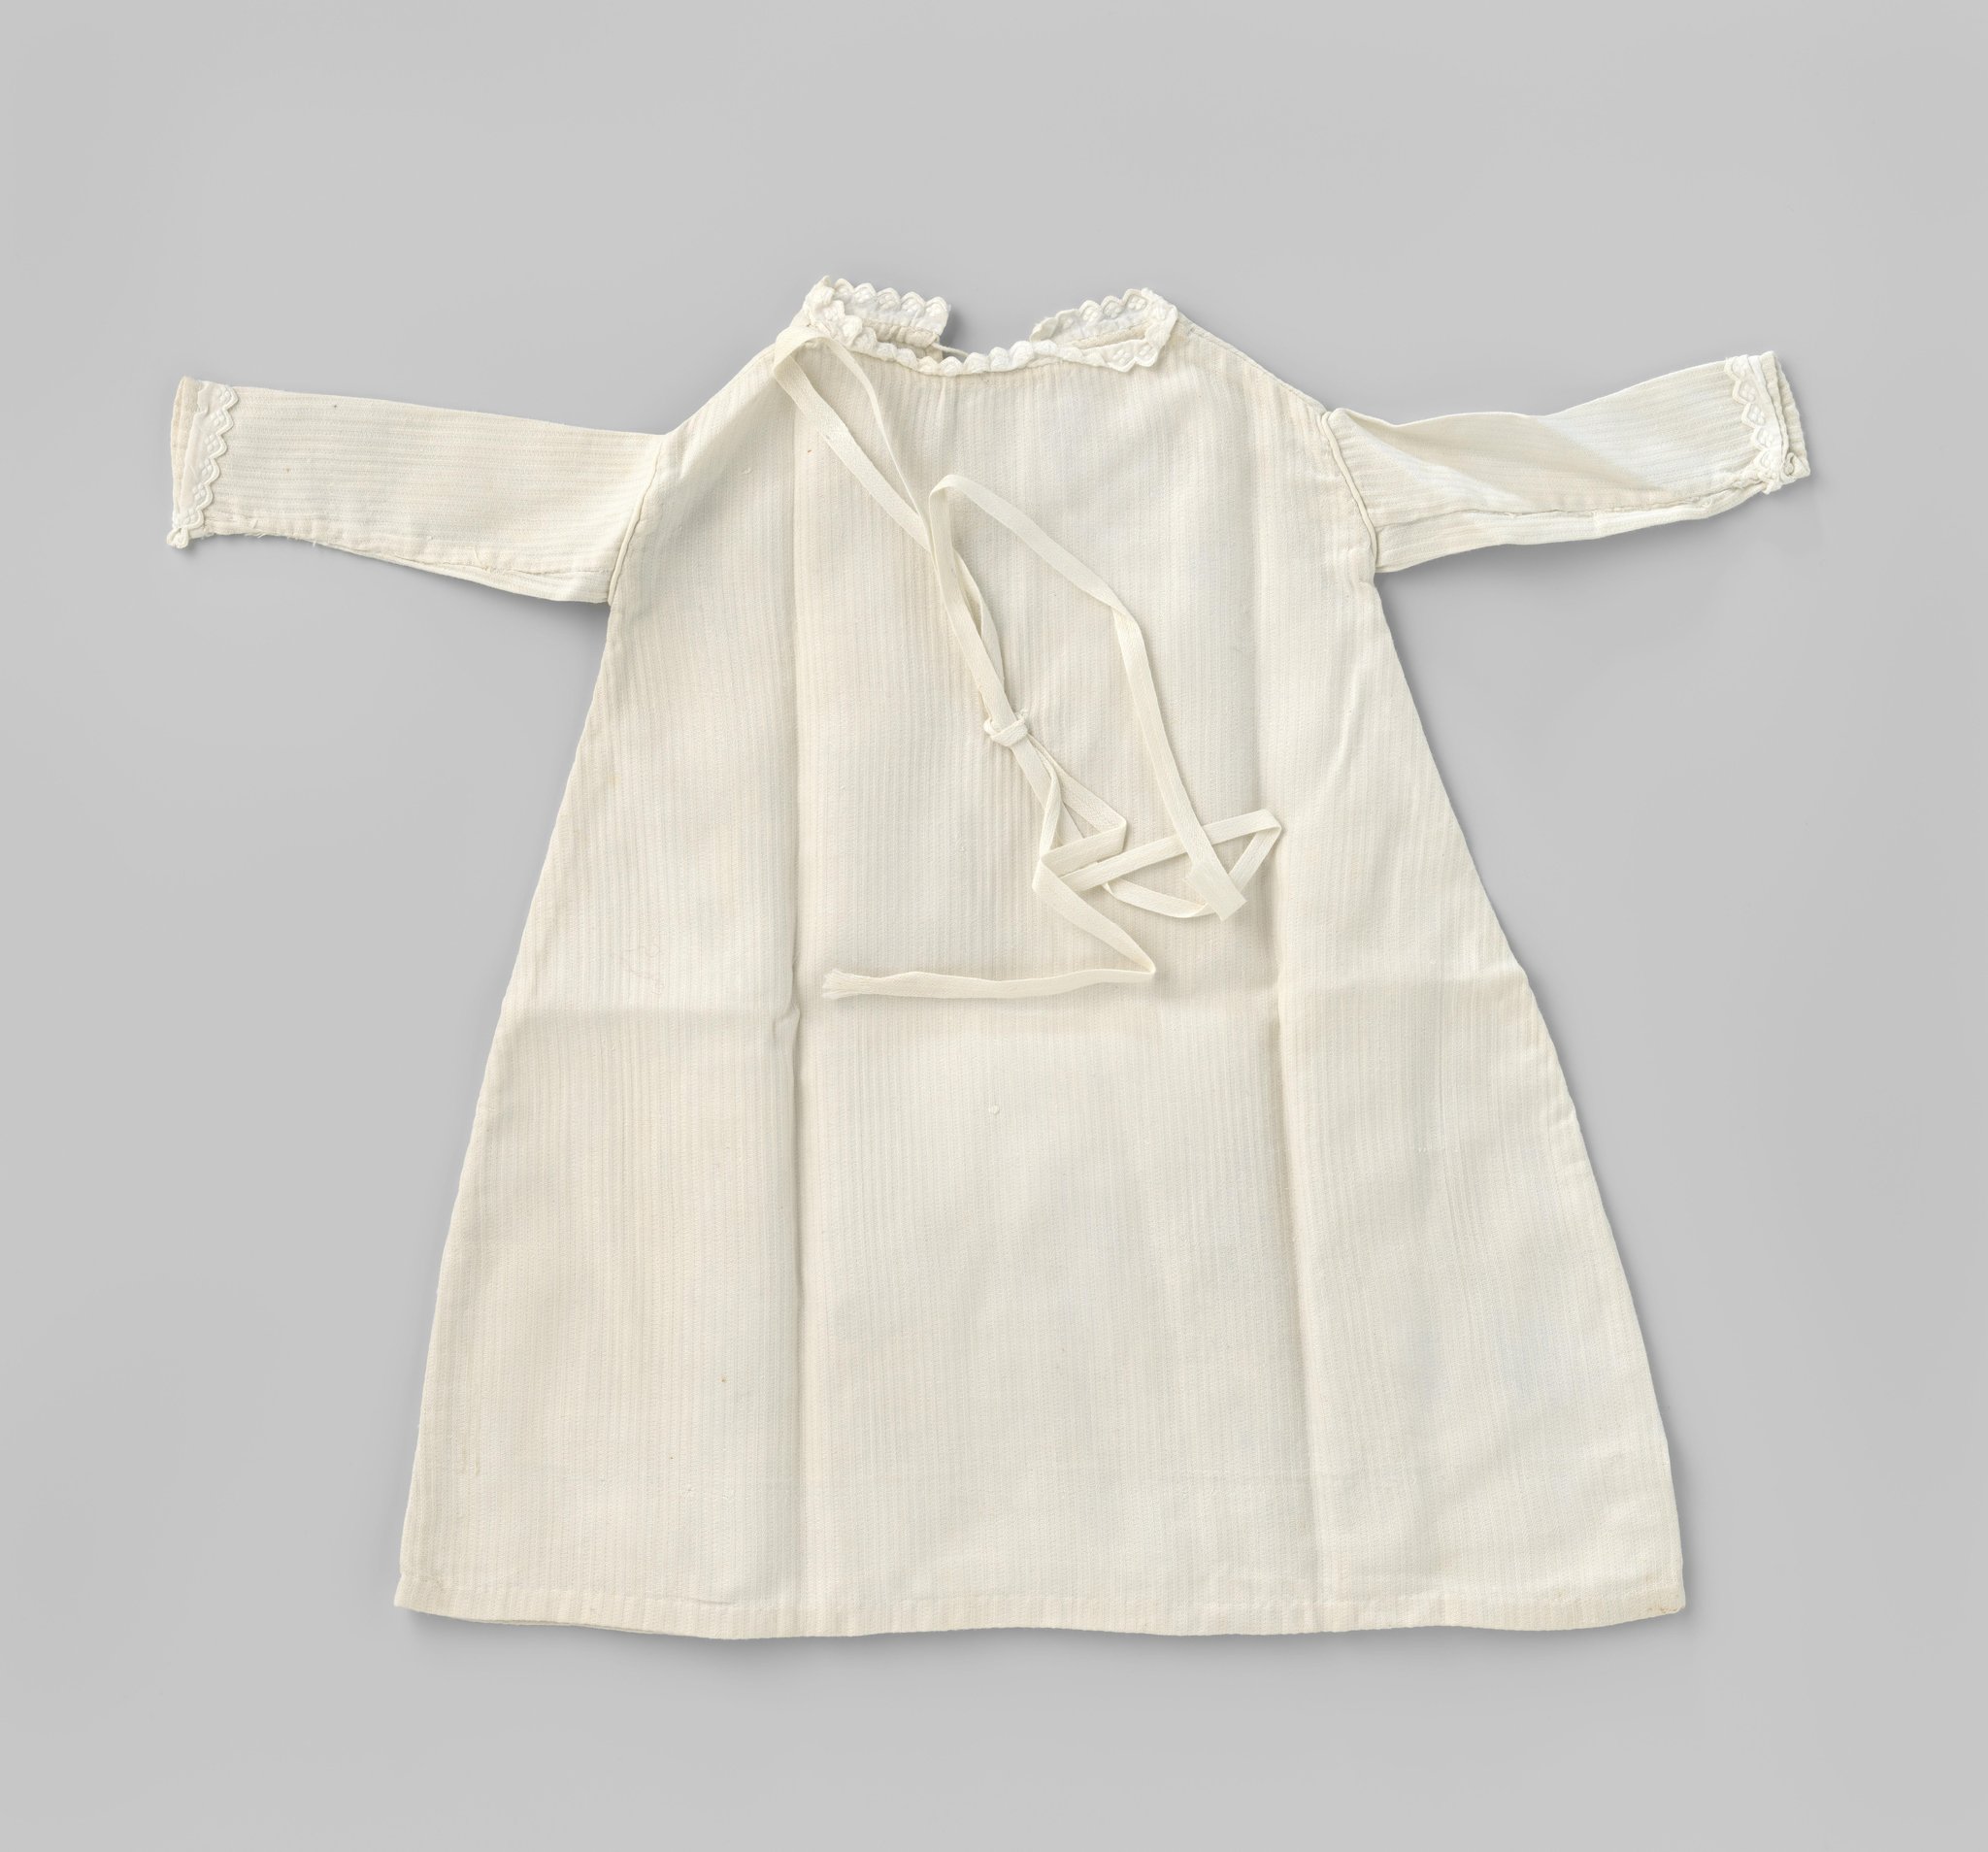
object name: doll's clothing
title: Hemd voor pop van wit linnen met ingeweven verticale strepen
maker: Anonymous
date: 1850-1920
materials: textile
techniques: weave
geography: netherlands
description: Het hemd heeft lange mouwen en is langs de hals en aan het uiteinde van de mouwen afgezet met een rand witte kant. Aan de voorzijde in het midden een wit lint.